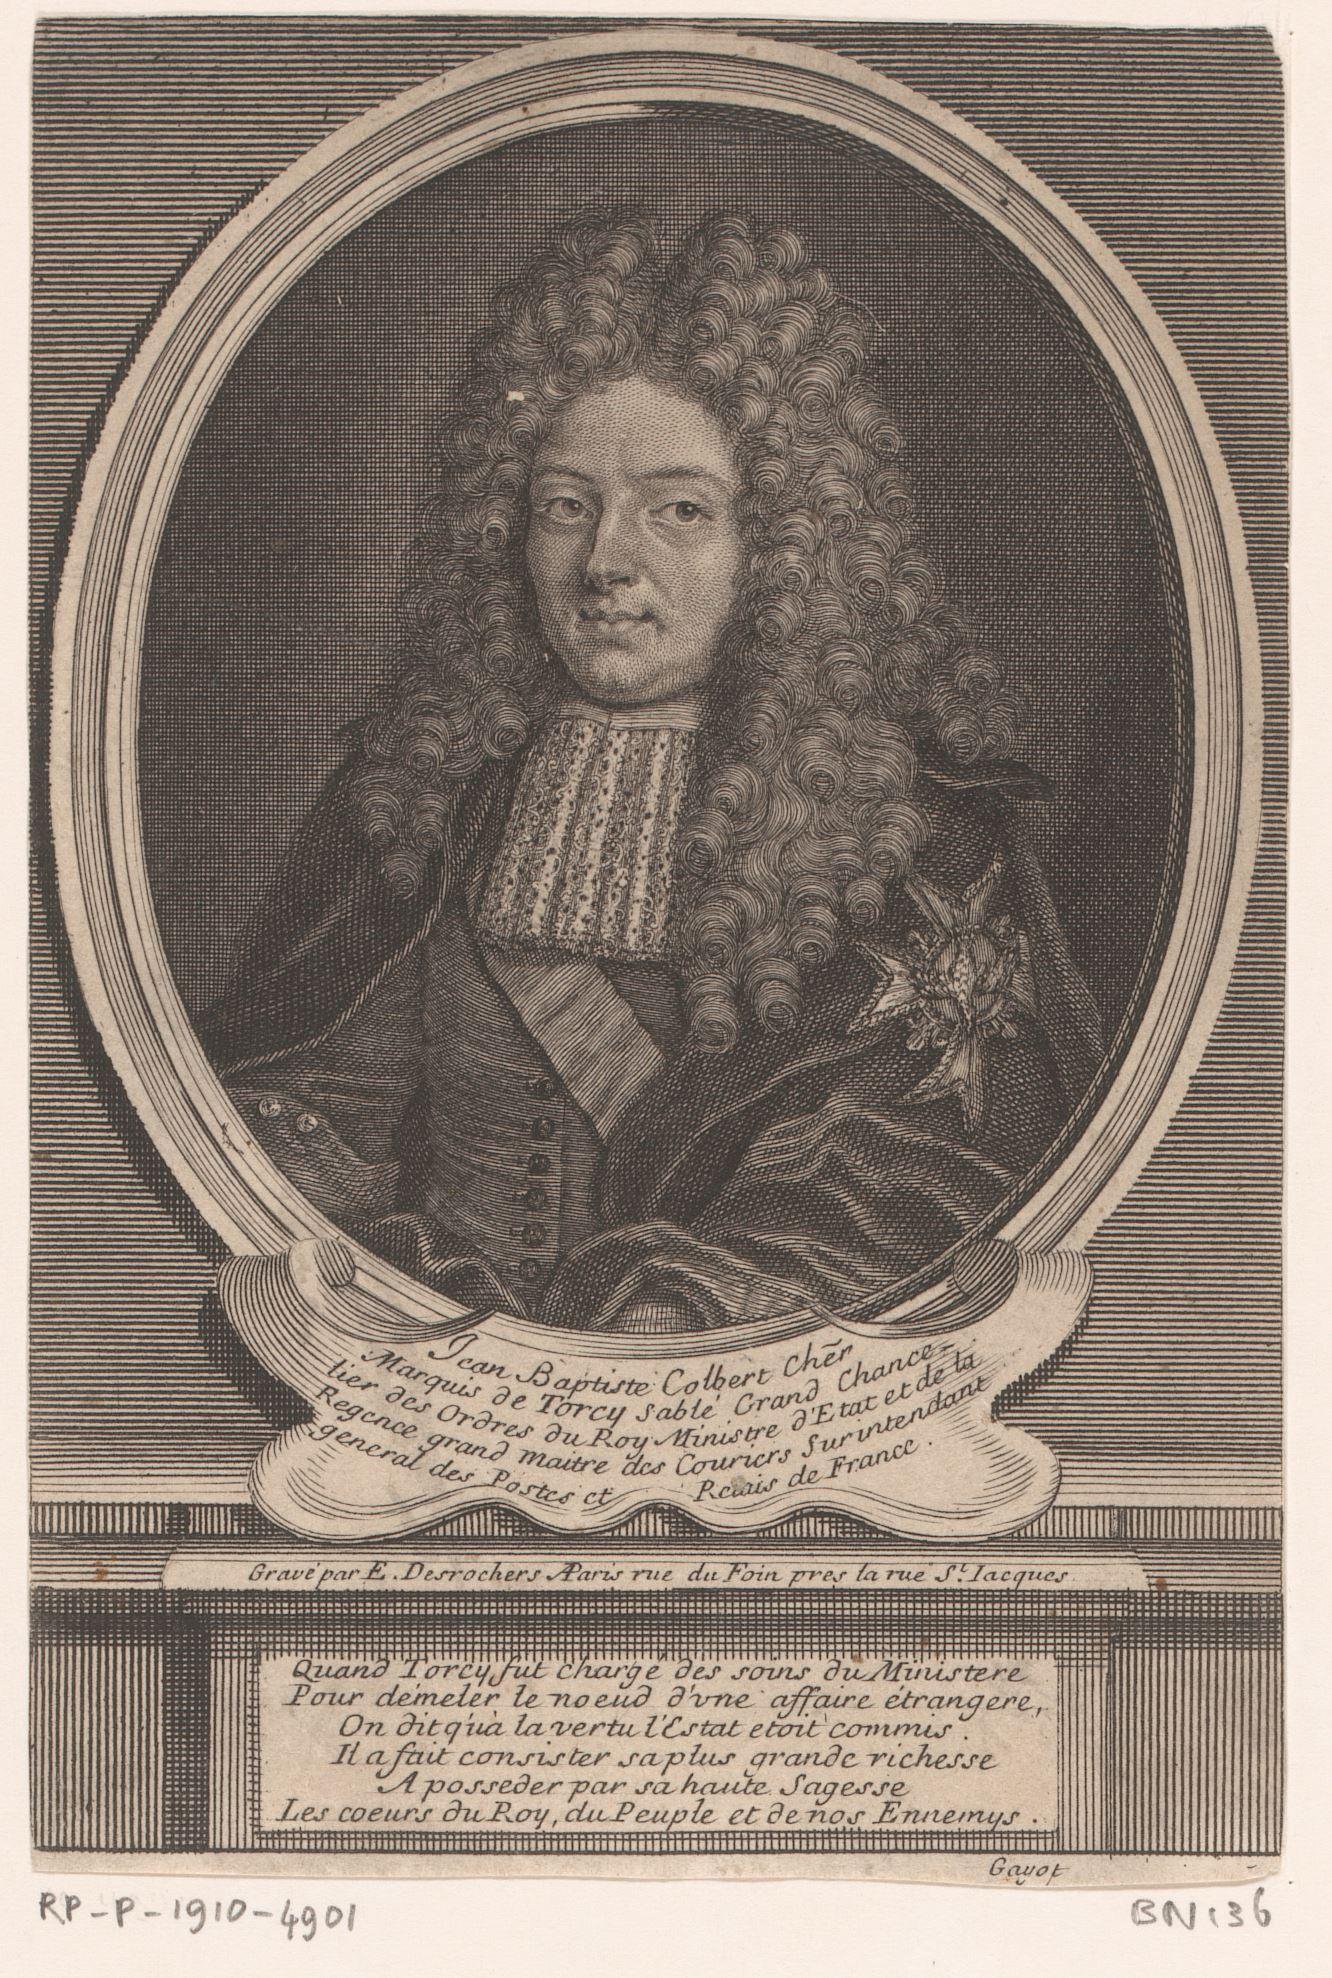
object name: print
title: Verzameling portretten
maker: étienne desrochers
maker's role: print maker, publisher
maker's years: 1668-1741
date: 1726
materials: paper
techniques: engraving, etching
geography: paris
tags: historical persons, diplomacy, diplomat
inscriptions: collector's mark: Lugt 2228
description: Behoort waarschijnlijk tot een serie portretten, grotendeels door Etienne Desrochers, getiteld: 'Recueil de portraits de personnes qui se sont distinguées tant dans les Armes que dans Belles-Lettres et les Arts, comme aussi la famille royale de France et autres cours étrangères'. De serie werd initieel uitgegeven door Desrochers en aangekondigd in 'Mercure' in mei 1726, p. 985. Echter was Desrochers reeds enkele jaren eerder begonnen met het uitgeven van de serie. Na de dood van Desrochers werd de serie voortgezet door Gilles Edme Petit. Een latere staat werd uitgegeven door Jean François Daumont in Parijs.